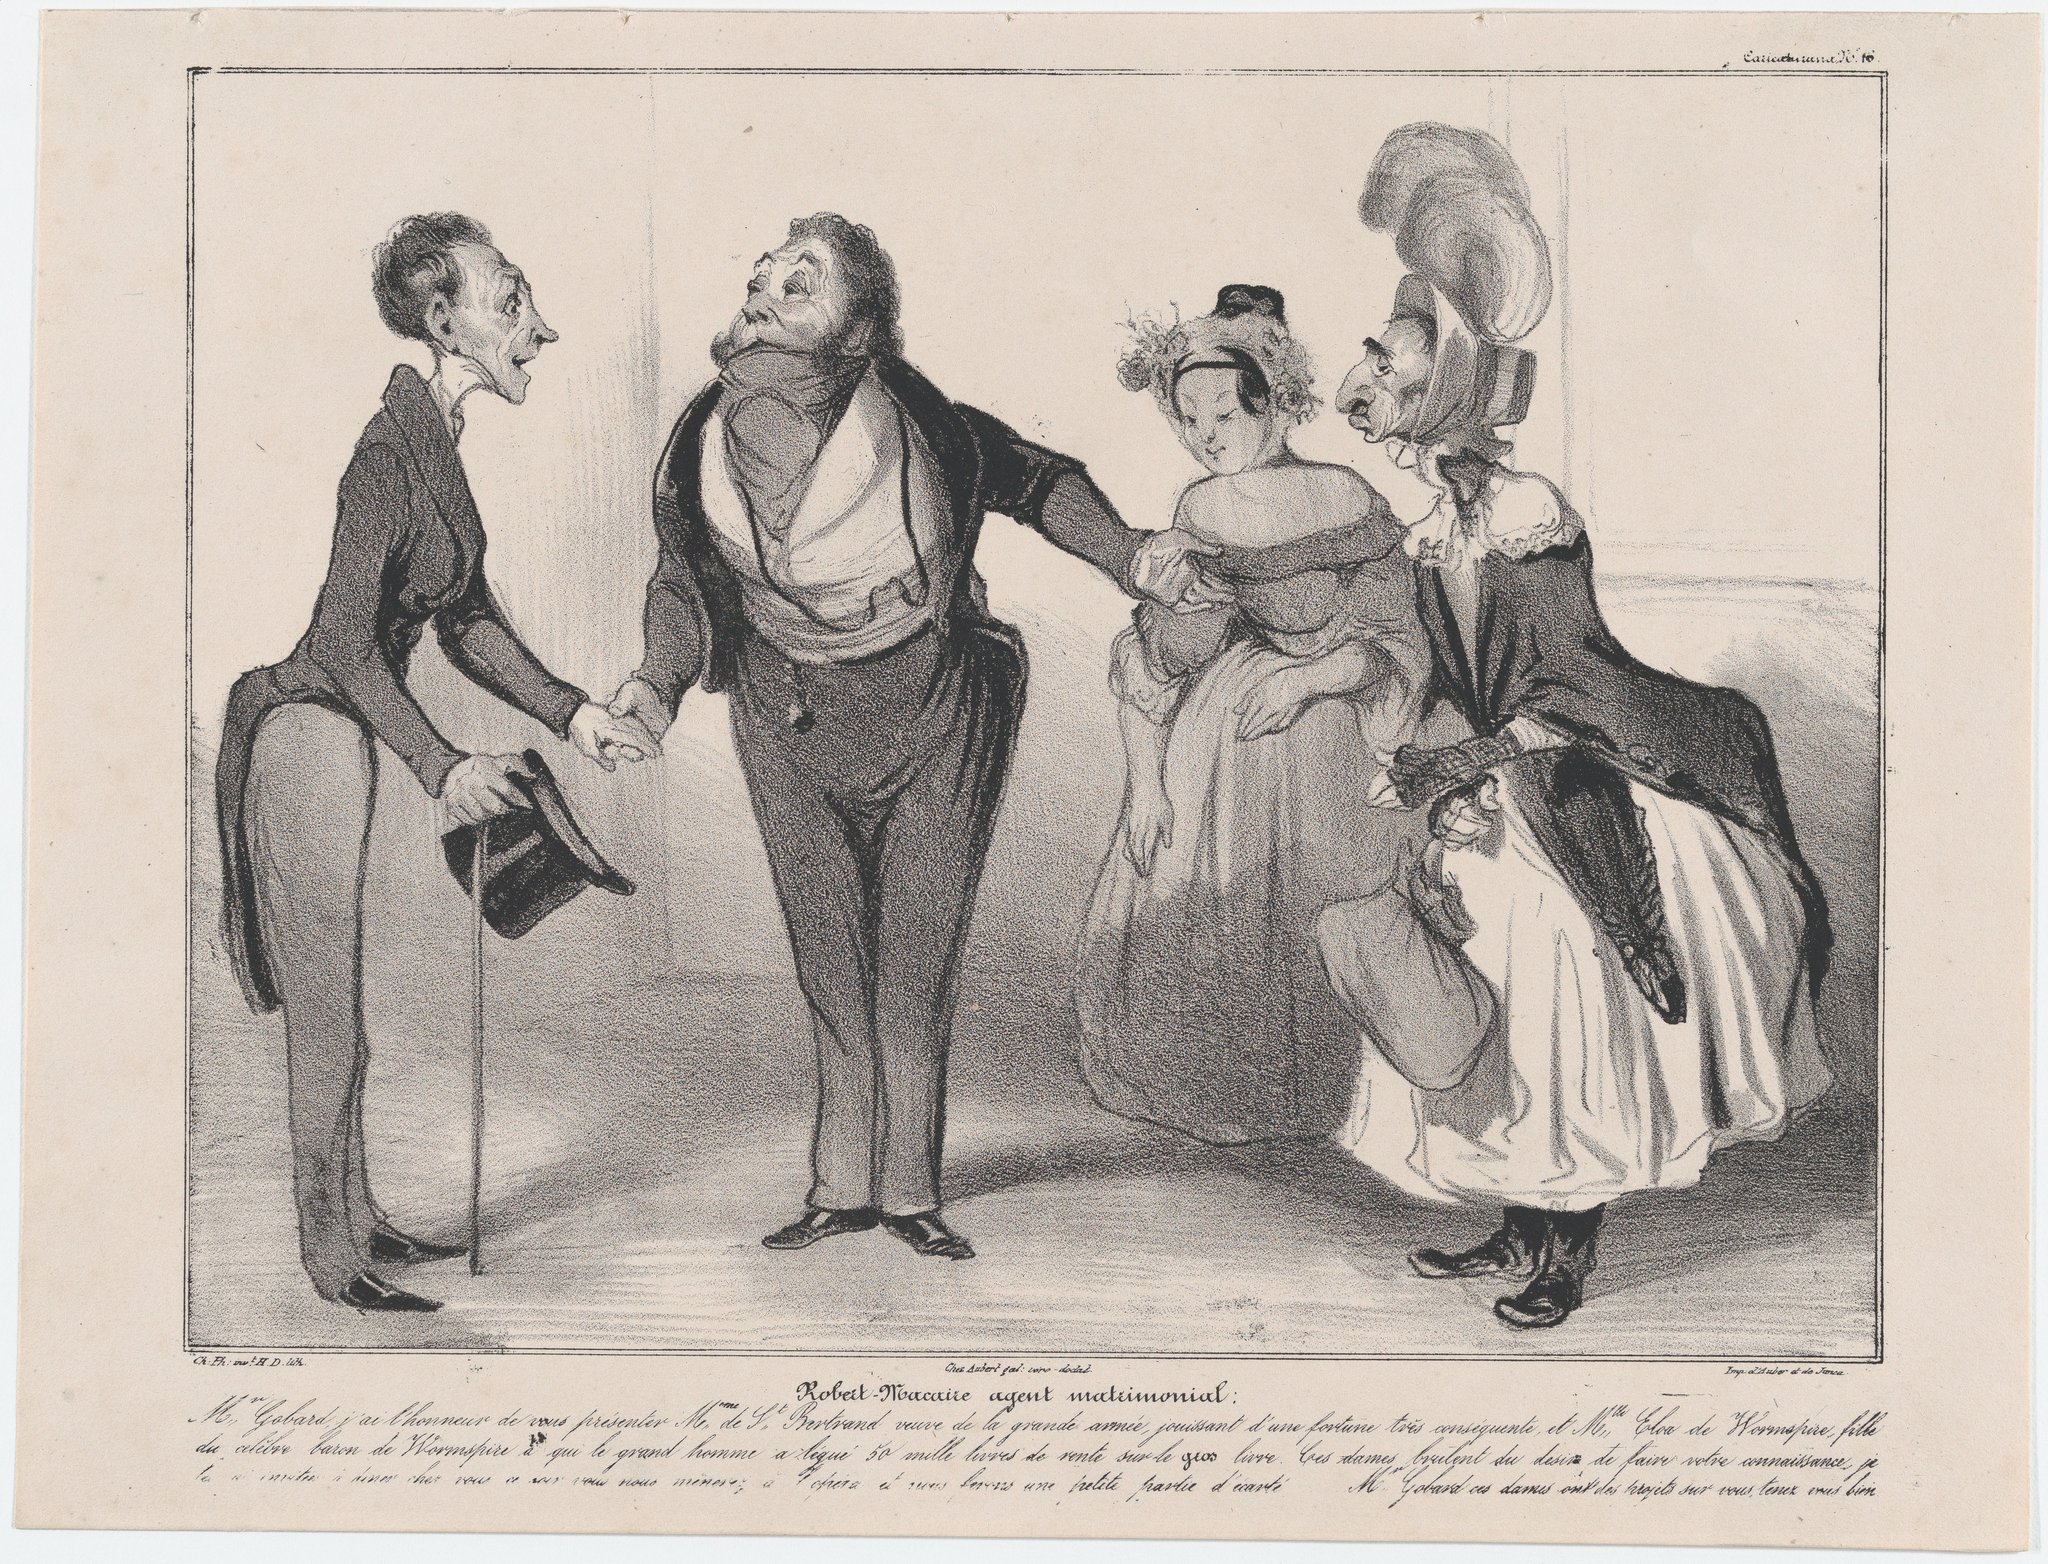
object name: print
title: Plate 16: Robert Macaire matrimonial agent, from 'Caricaturana,' published in Les Robert Macaires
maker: honoré daumier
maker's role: artist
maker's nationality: french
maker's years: 1808-1879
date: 1838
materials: paper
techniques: lithograph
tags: men,women